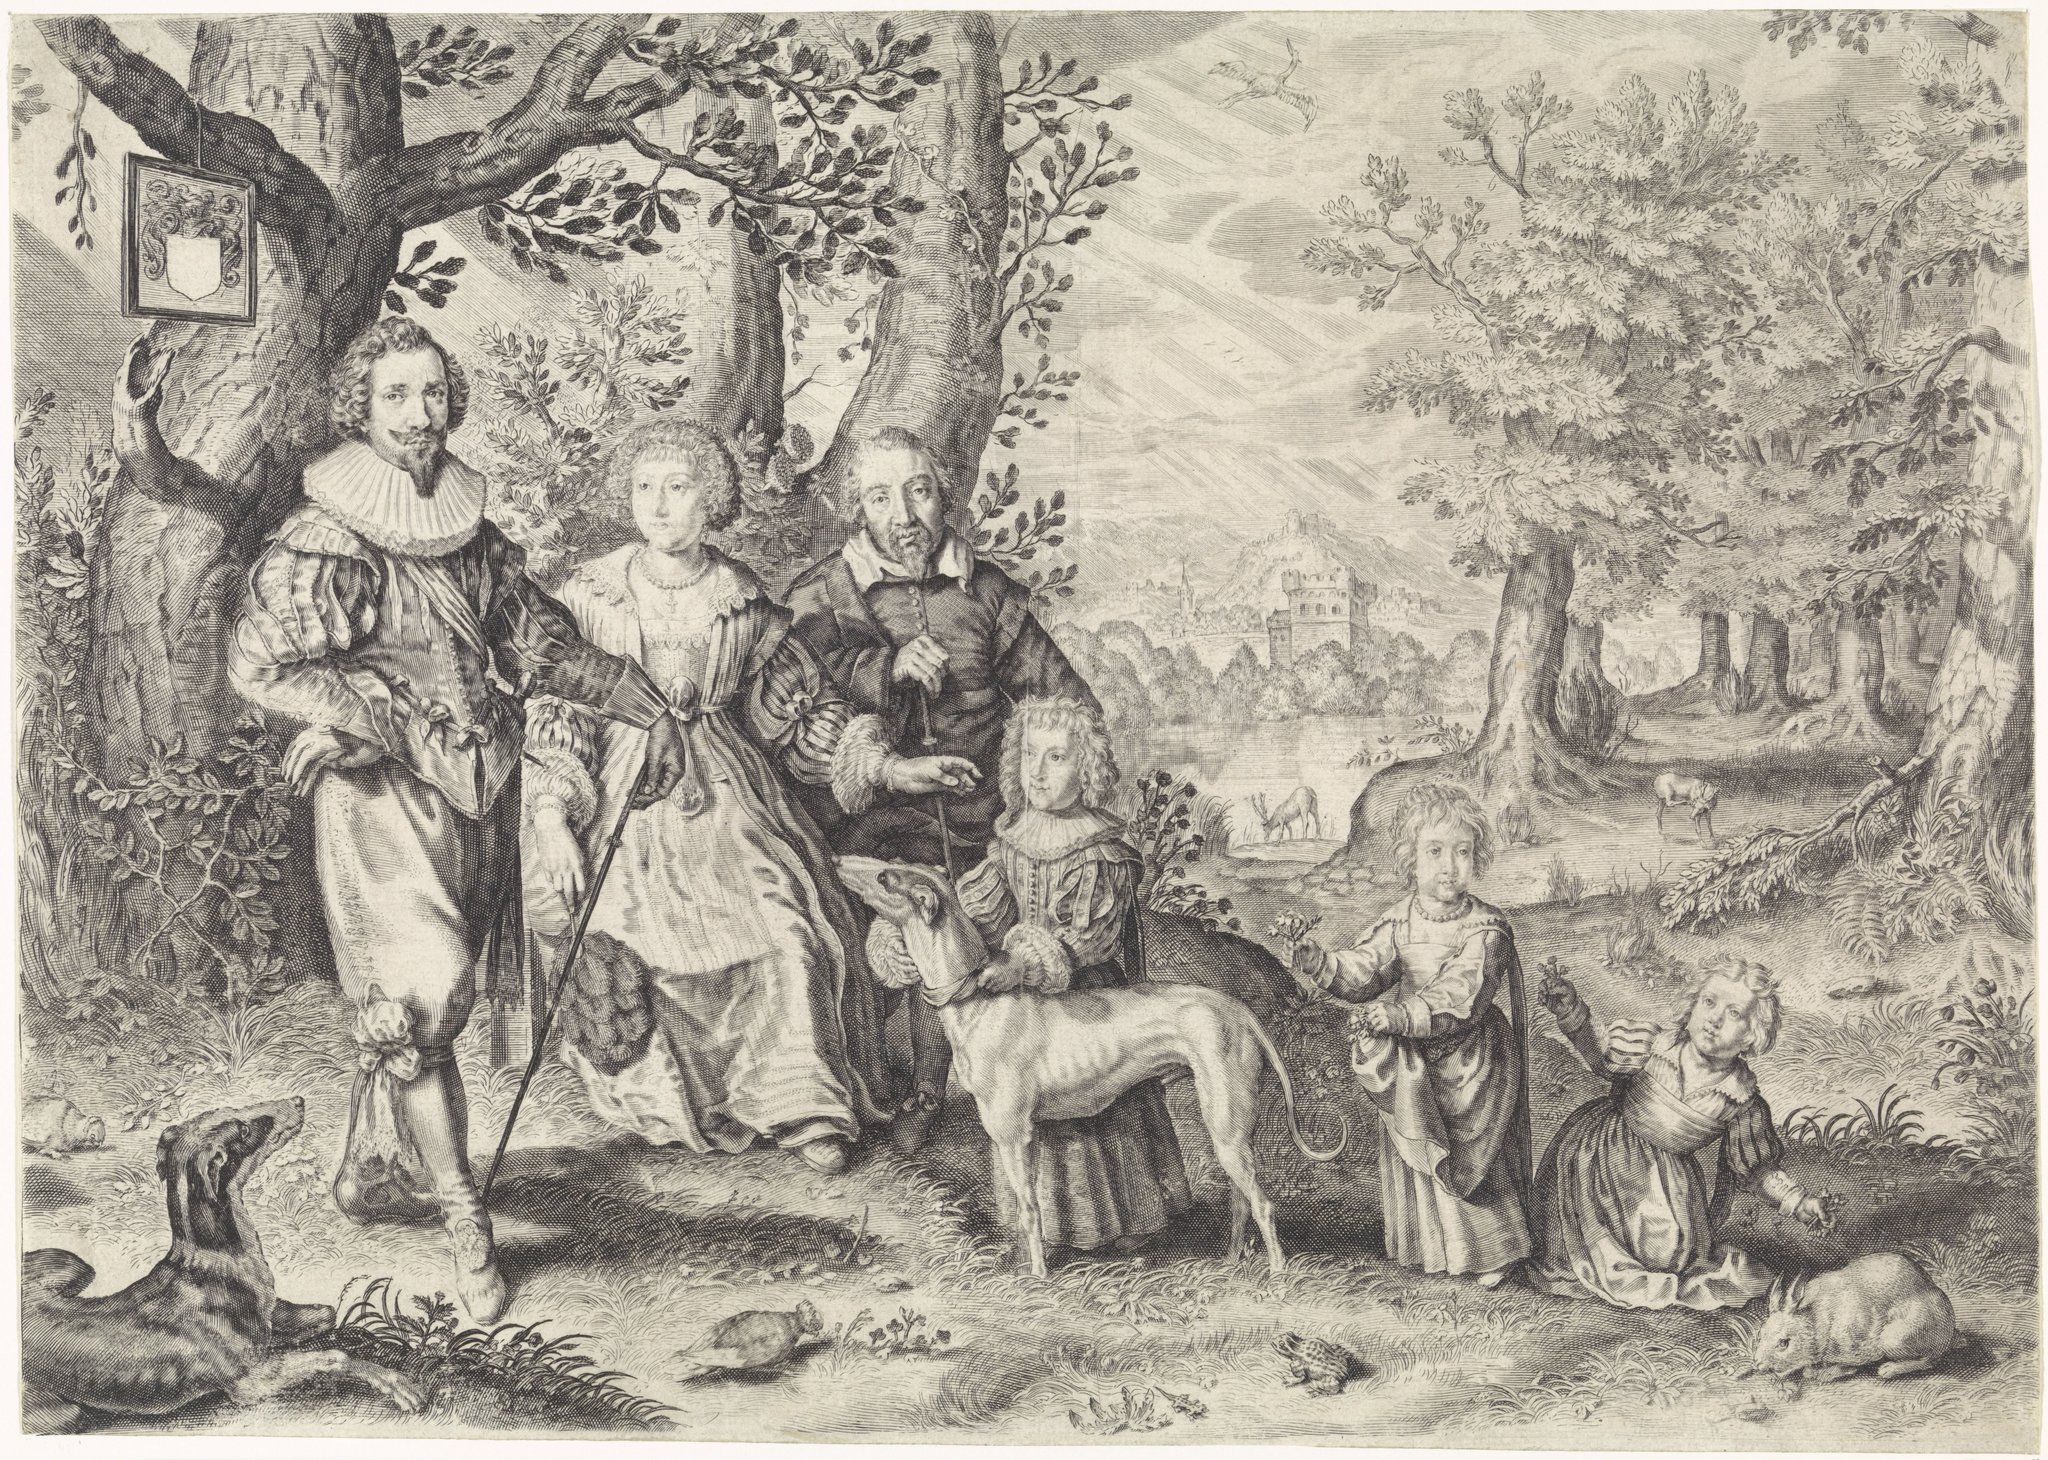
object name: print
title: Portret van Guy Michel Lejay en zijn familie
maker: crispijn van de passe (ii)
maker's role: draughtsman, print maker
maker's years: 1594-1670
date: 1618-1630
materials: paper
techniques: engraving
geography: paris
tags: paris, tailless amphibians: frog, hoofed animals: deer, historical persons, landscape with tower or castle, rodents: rabbit, dog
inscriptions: inscription: ‘N. 5038’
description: Landschap met de advocaat Guy Michel Lejay, ook wel "la Polyglotte" genoemd, de markies en markiezin De la Chassetière en hun drie jonge kinderen. Het wapenschild van de familie hangt aan een boom. Op de voorgrond diverse dieren (hond, vogel, kikker, konijn). Op de achtergrond een kasteel en twee herten bij een meer.